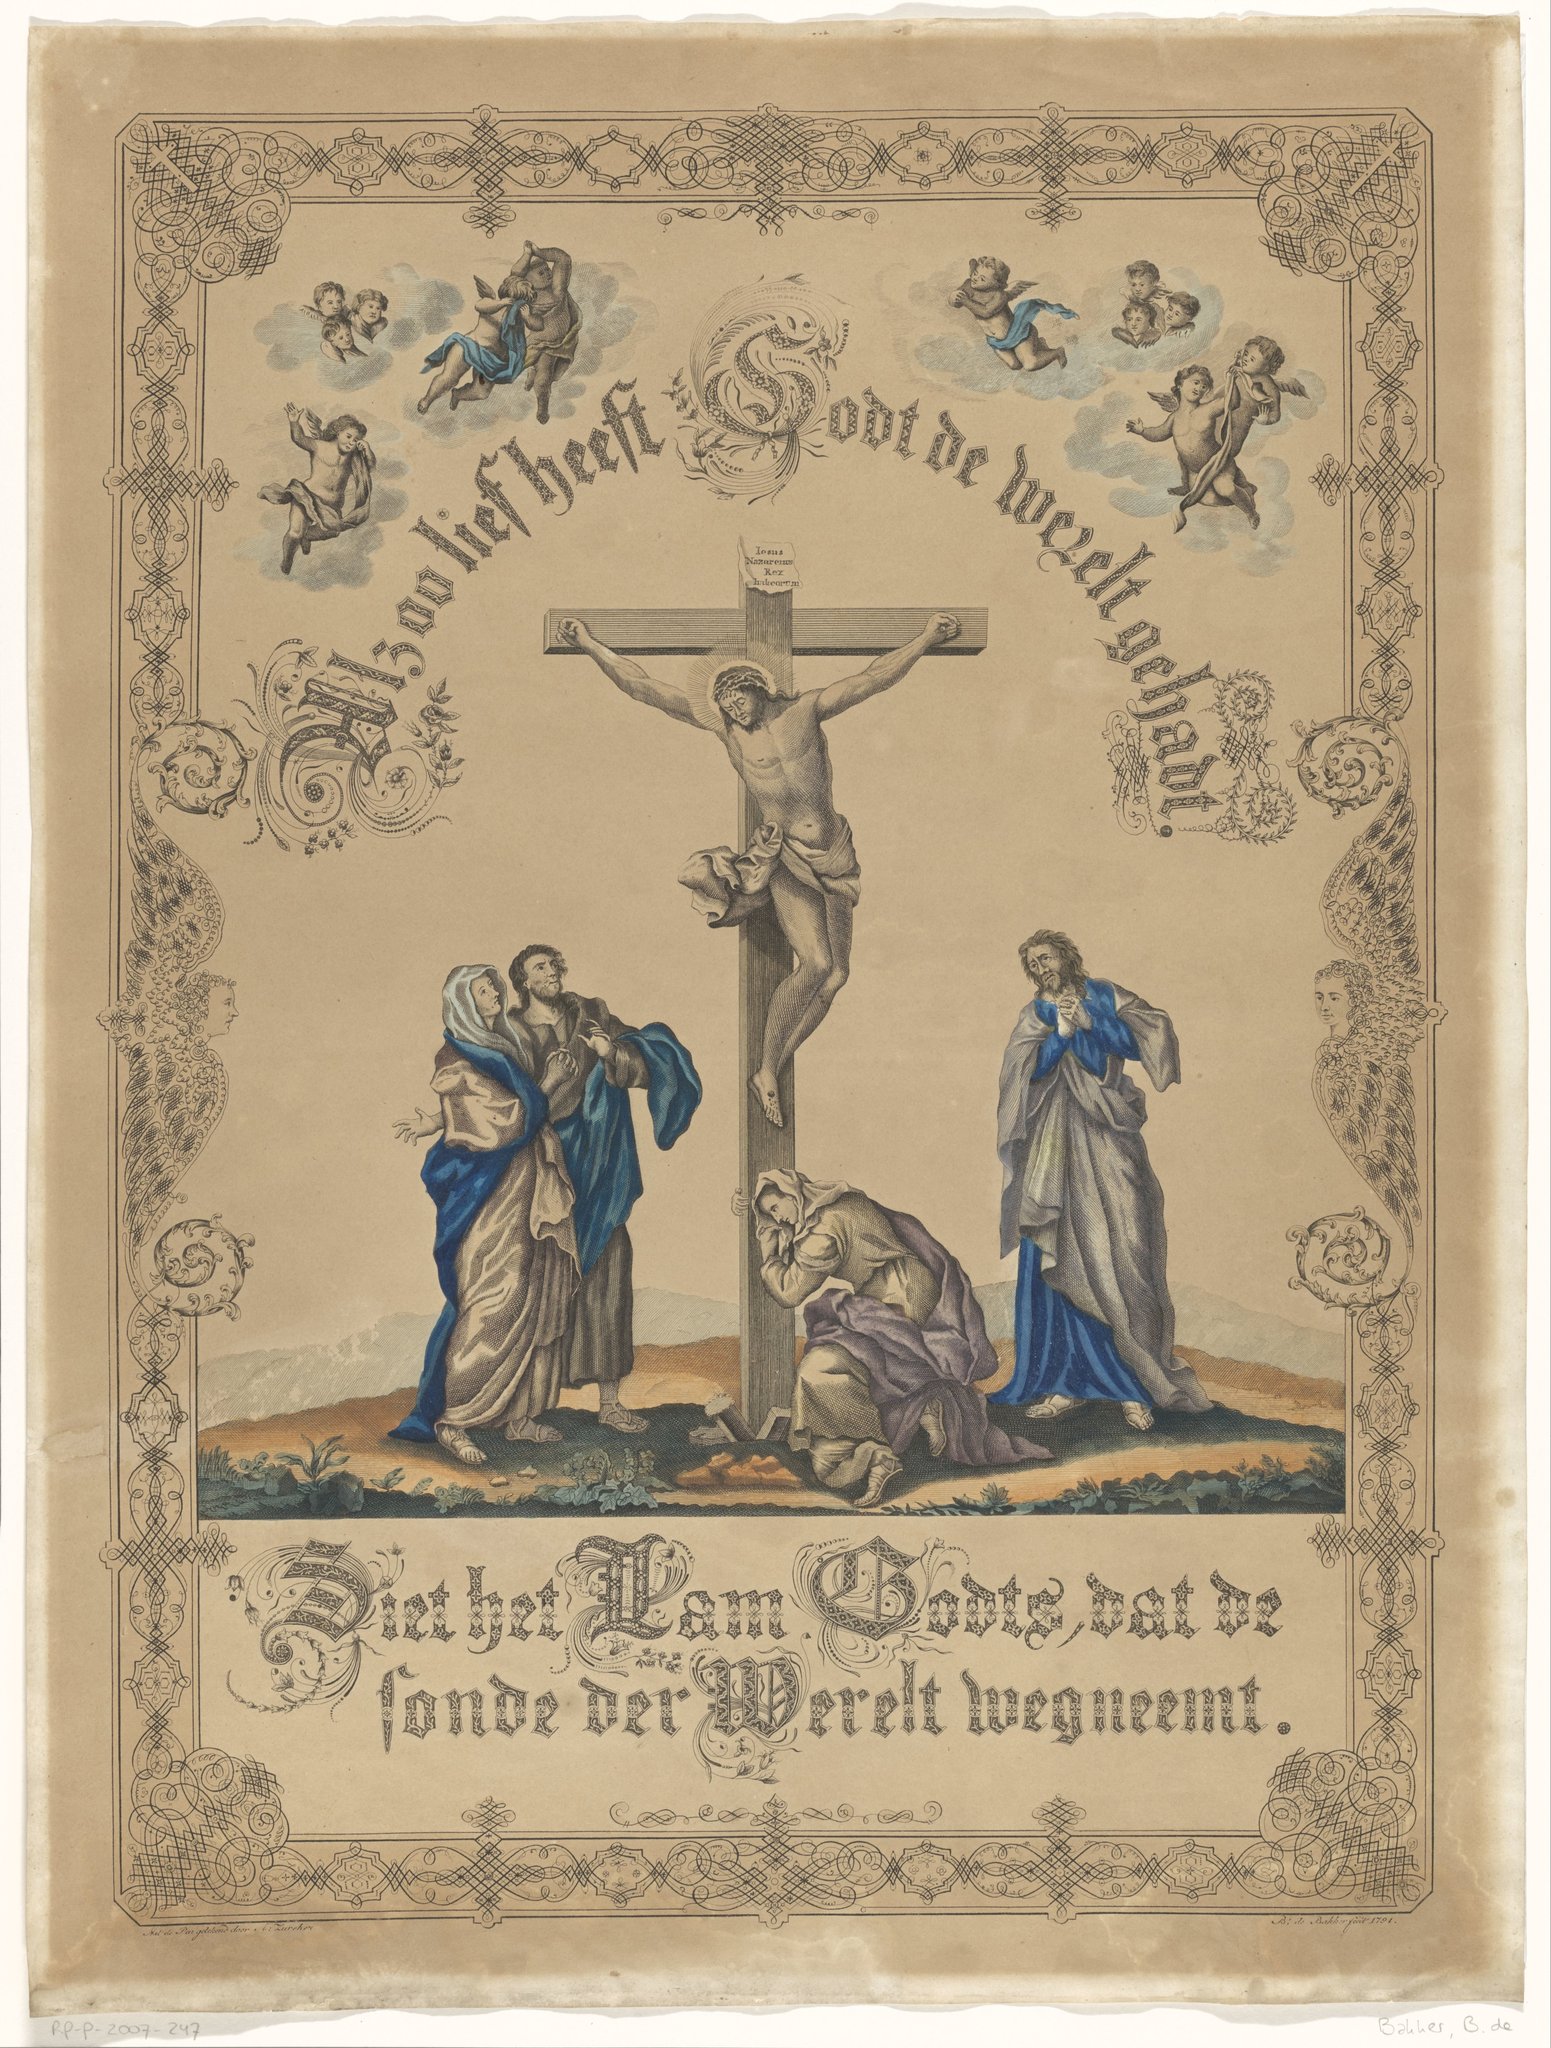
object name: print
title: Gekruisigde Christus met Maria en Johannes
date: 1791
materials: paper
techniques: engraving